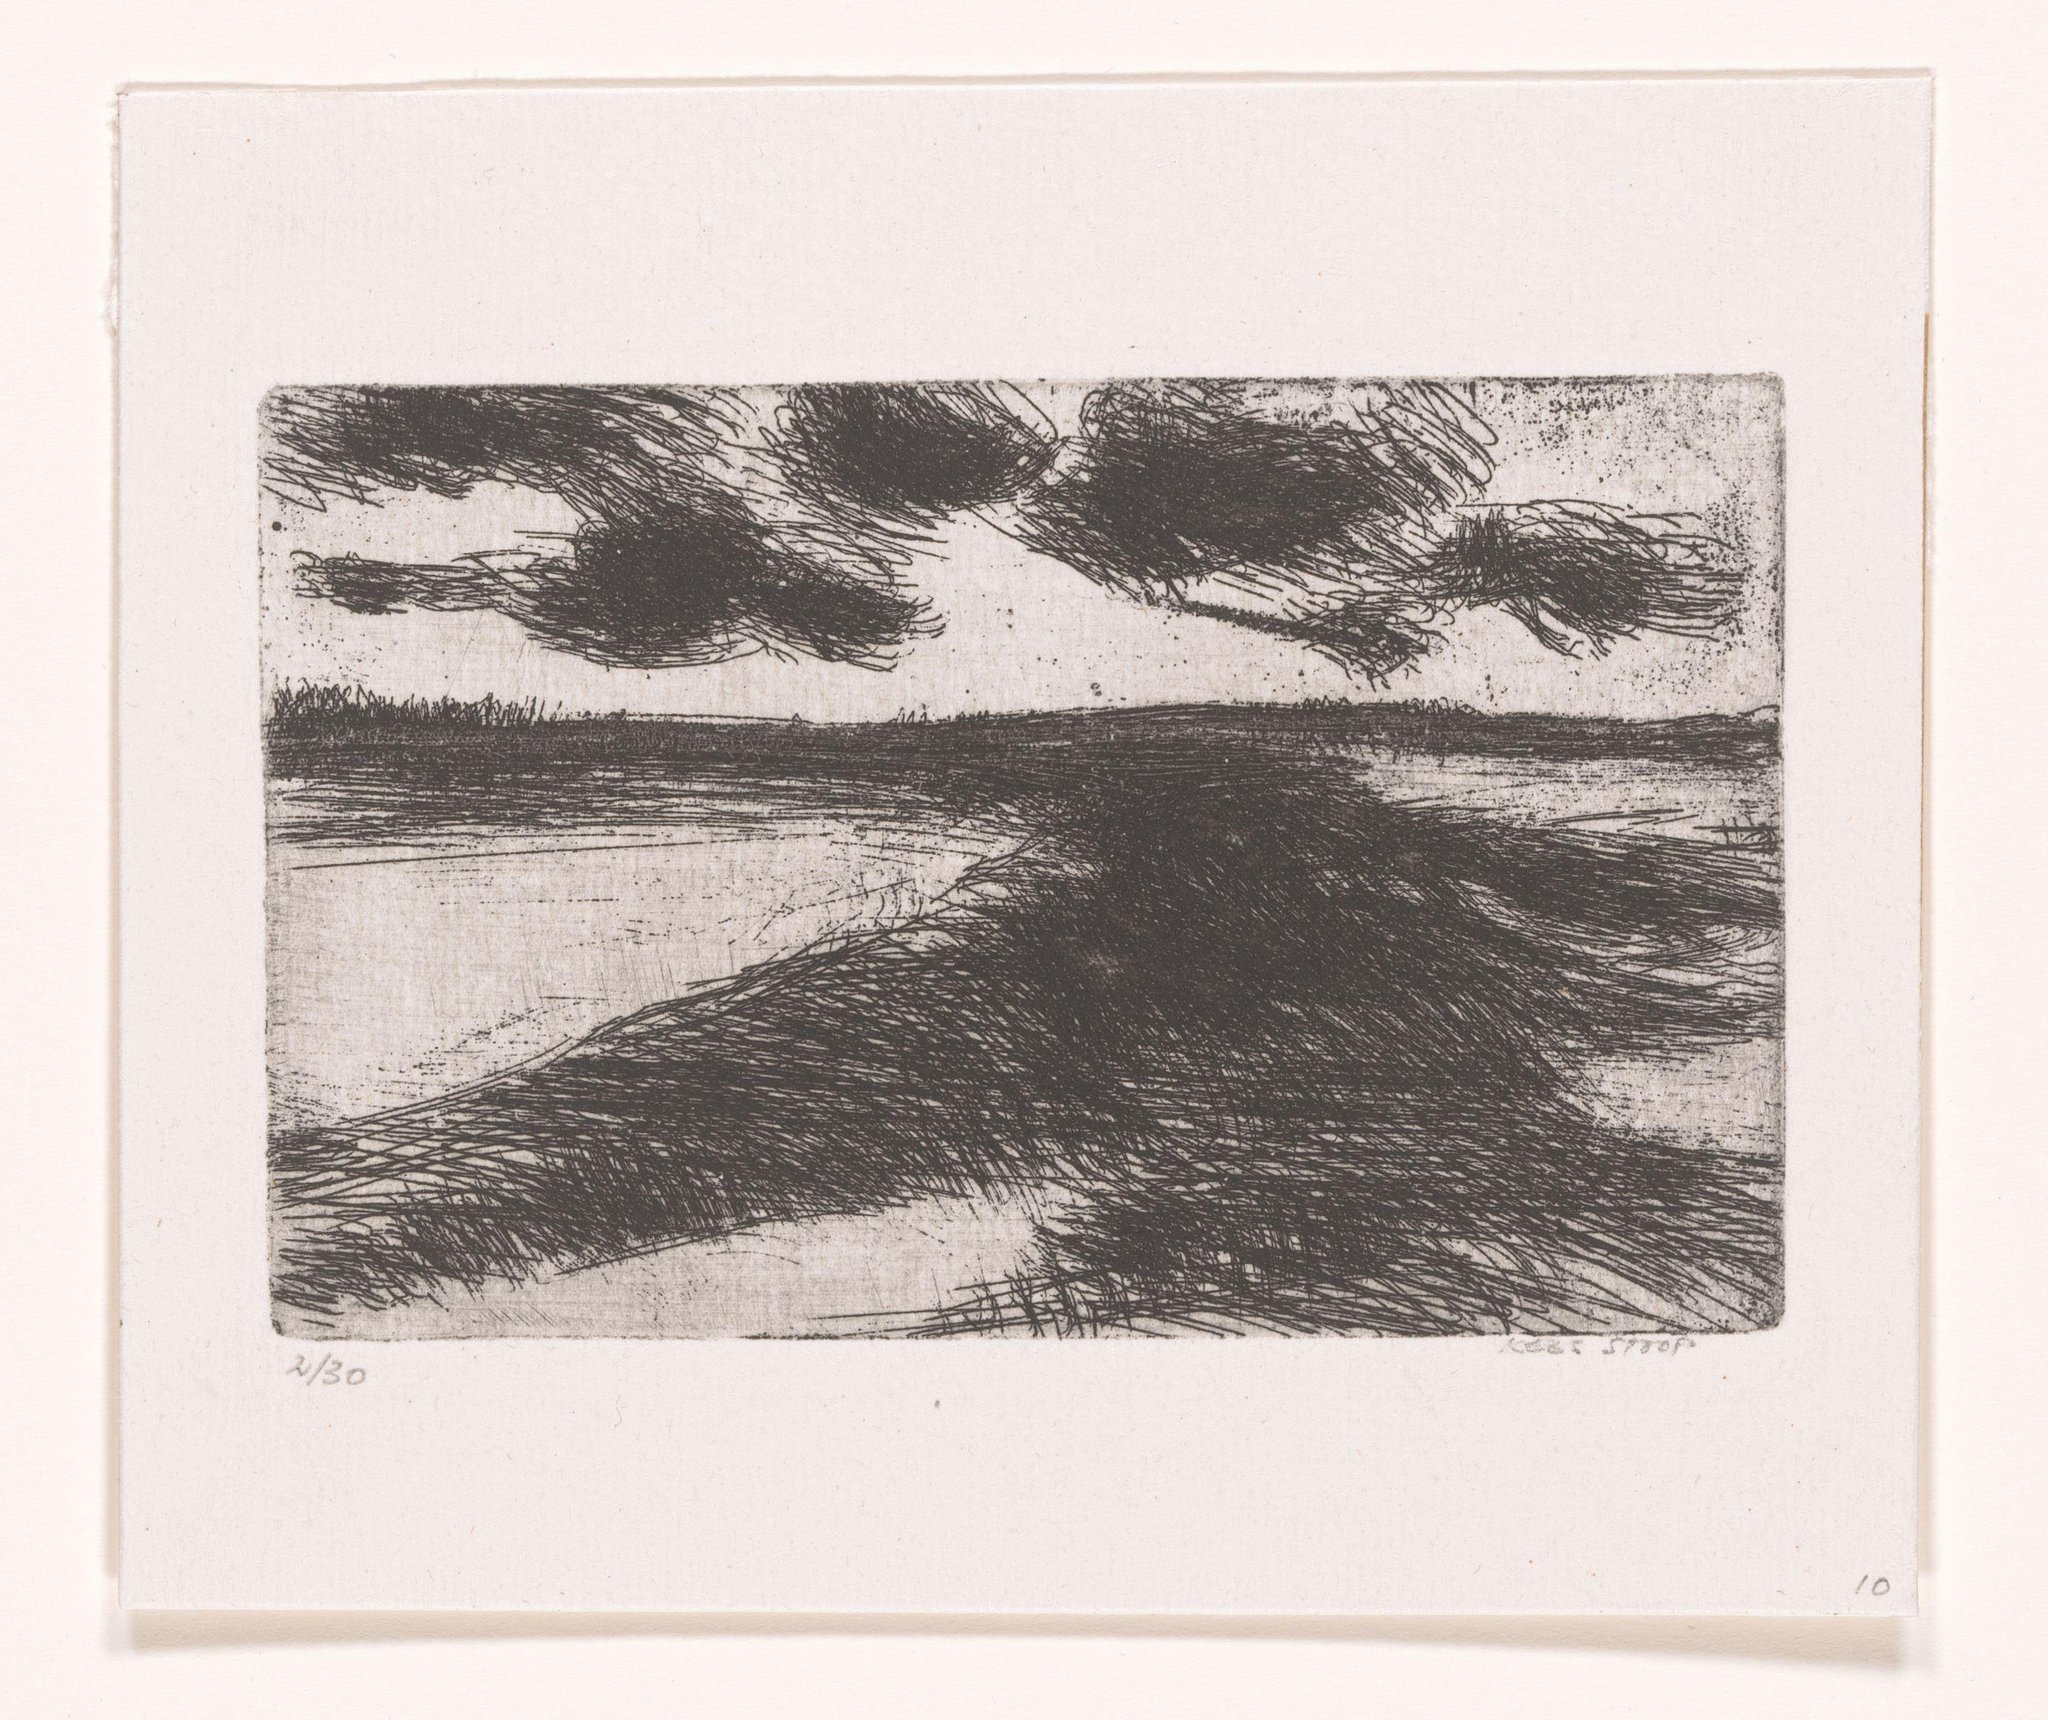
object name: print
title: Zwarte wolken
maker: kees stoop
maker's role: draughtsman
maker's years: 1929-2019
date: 1944-1990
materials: paper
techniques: etching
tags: clouds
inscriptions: signature: ‘KEES STOOP’, edition: ‘2/30’